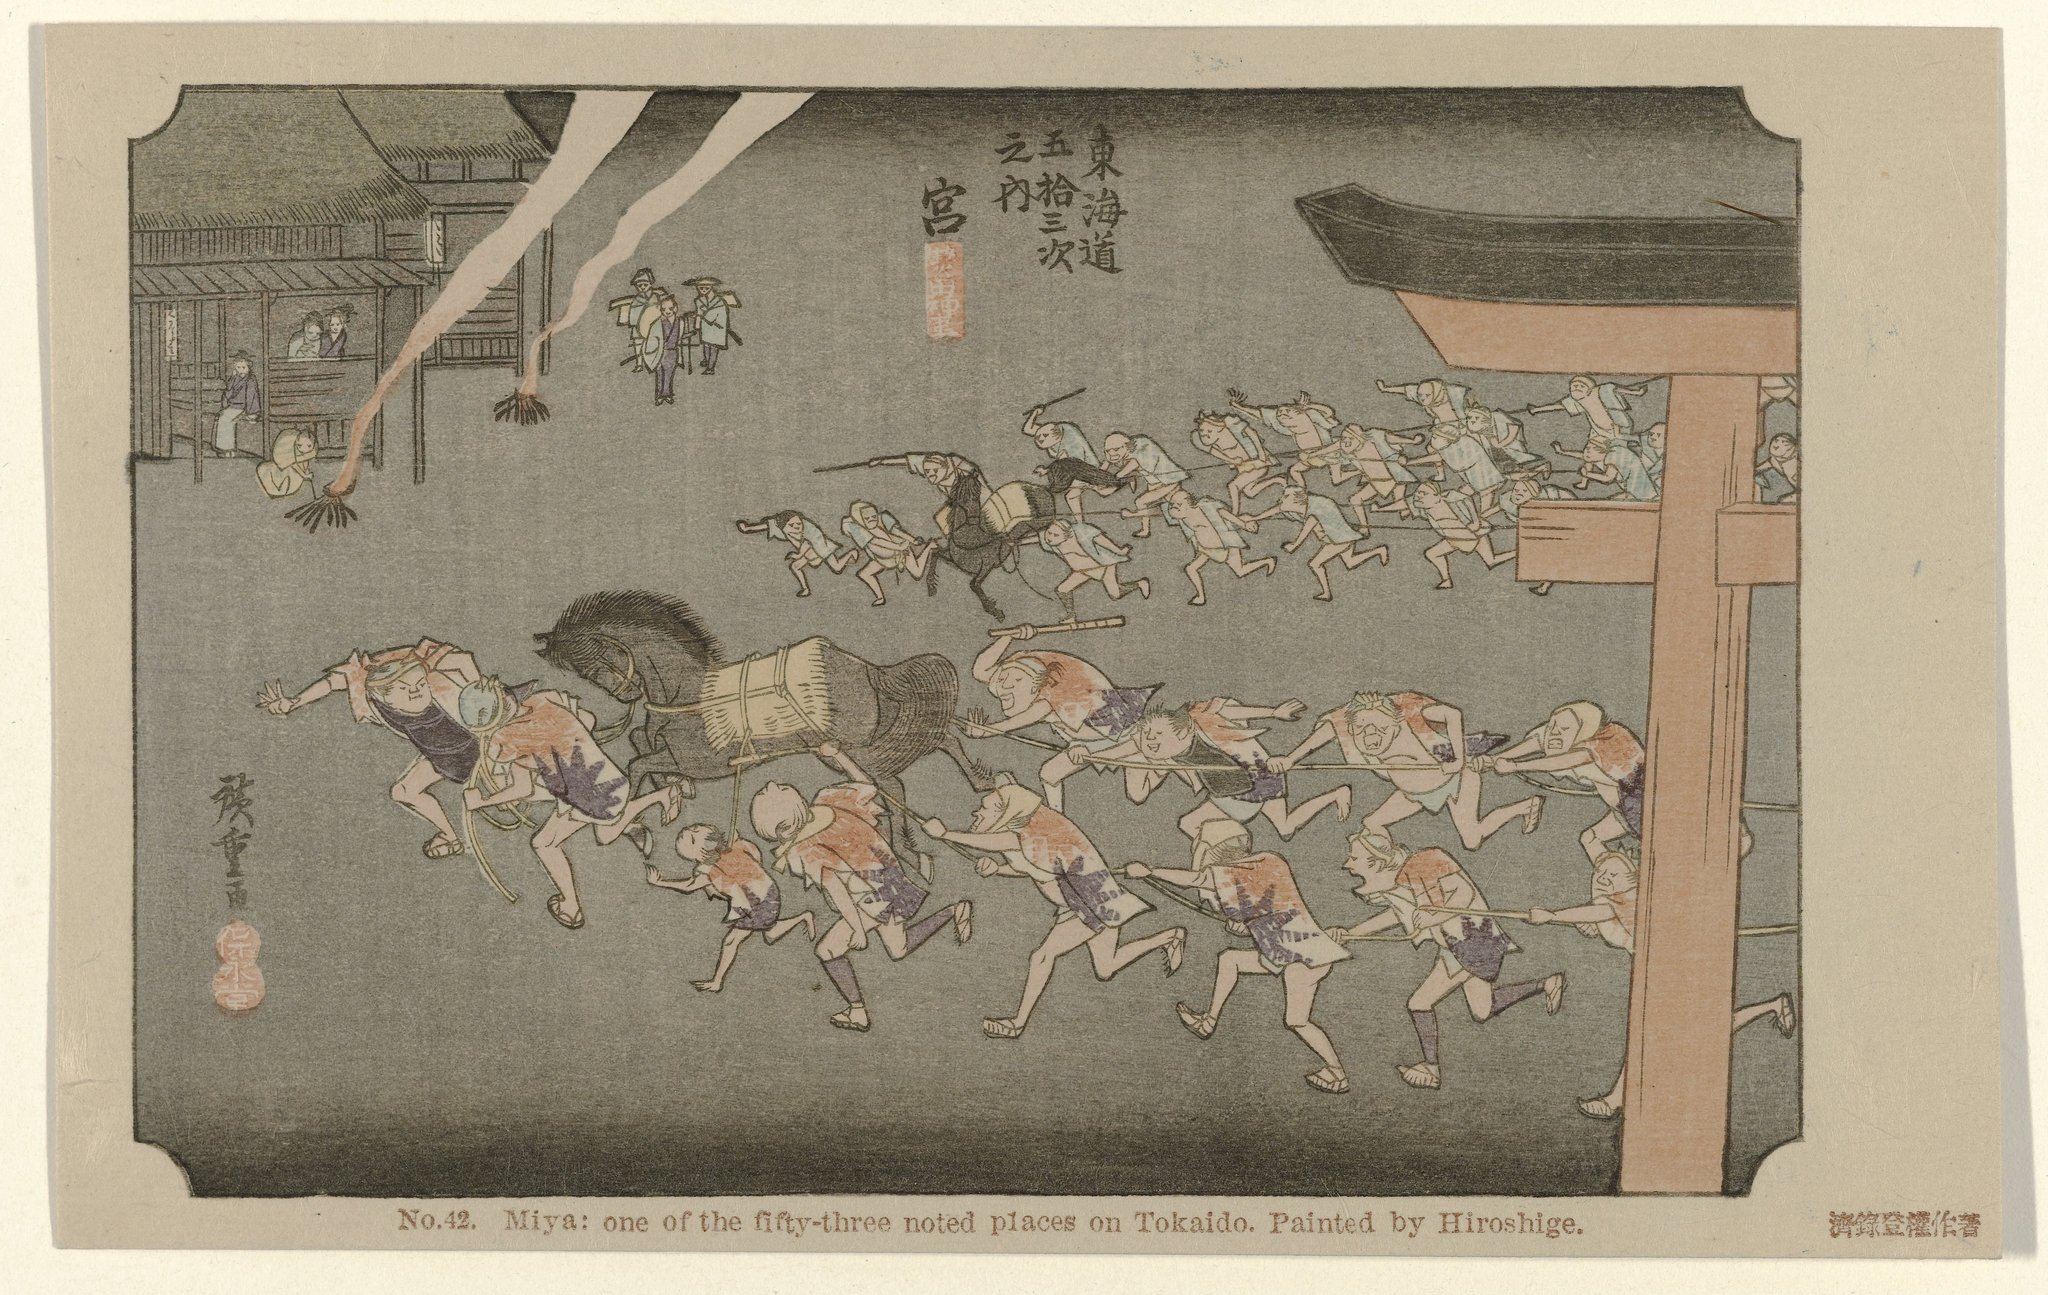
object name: ansichtkaart, prentbriefkaart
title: No. 42. Miya: one of the fifty-three noted places on Tokaido, painted by Hiroshige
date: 1906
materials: cardboard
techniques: woodcut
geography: japan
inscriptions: date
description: Twee groepen mannen trekken aan touwen van festival wagens, rechts is nog de toegangspoort van de Miya schrijn te zien.